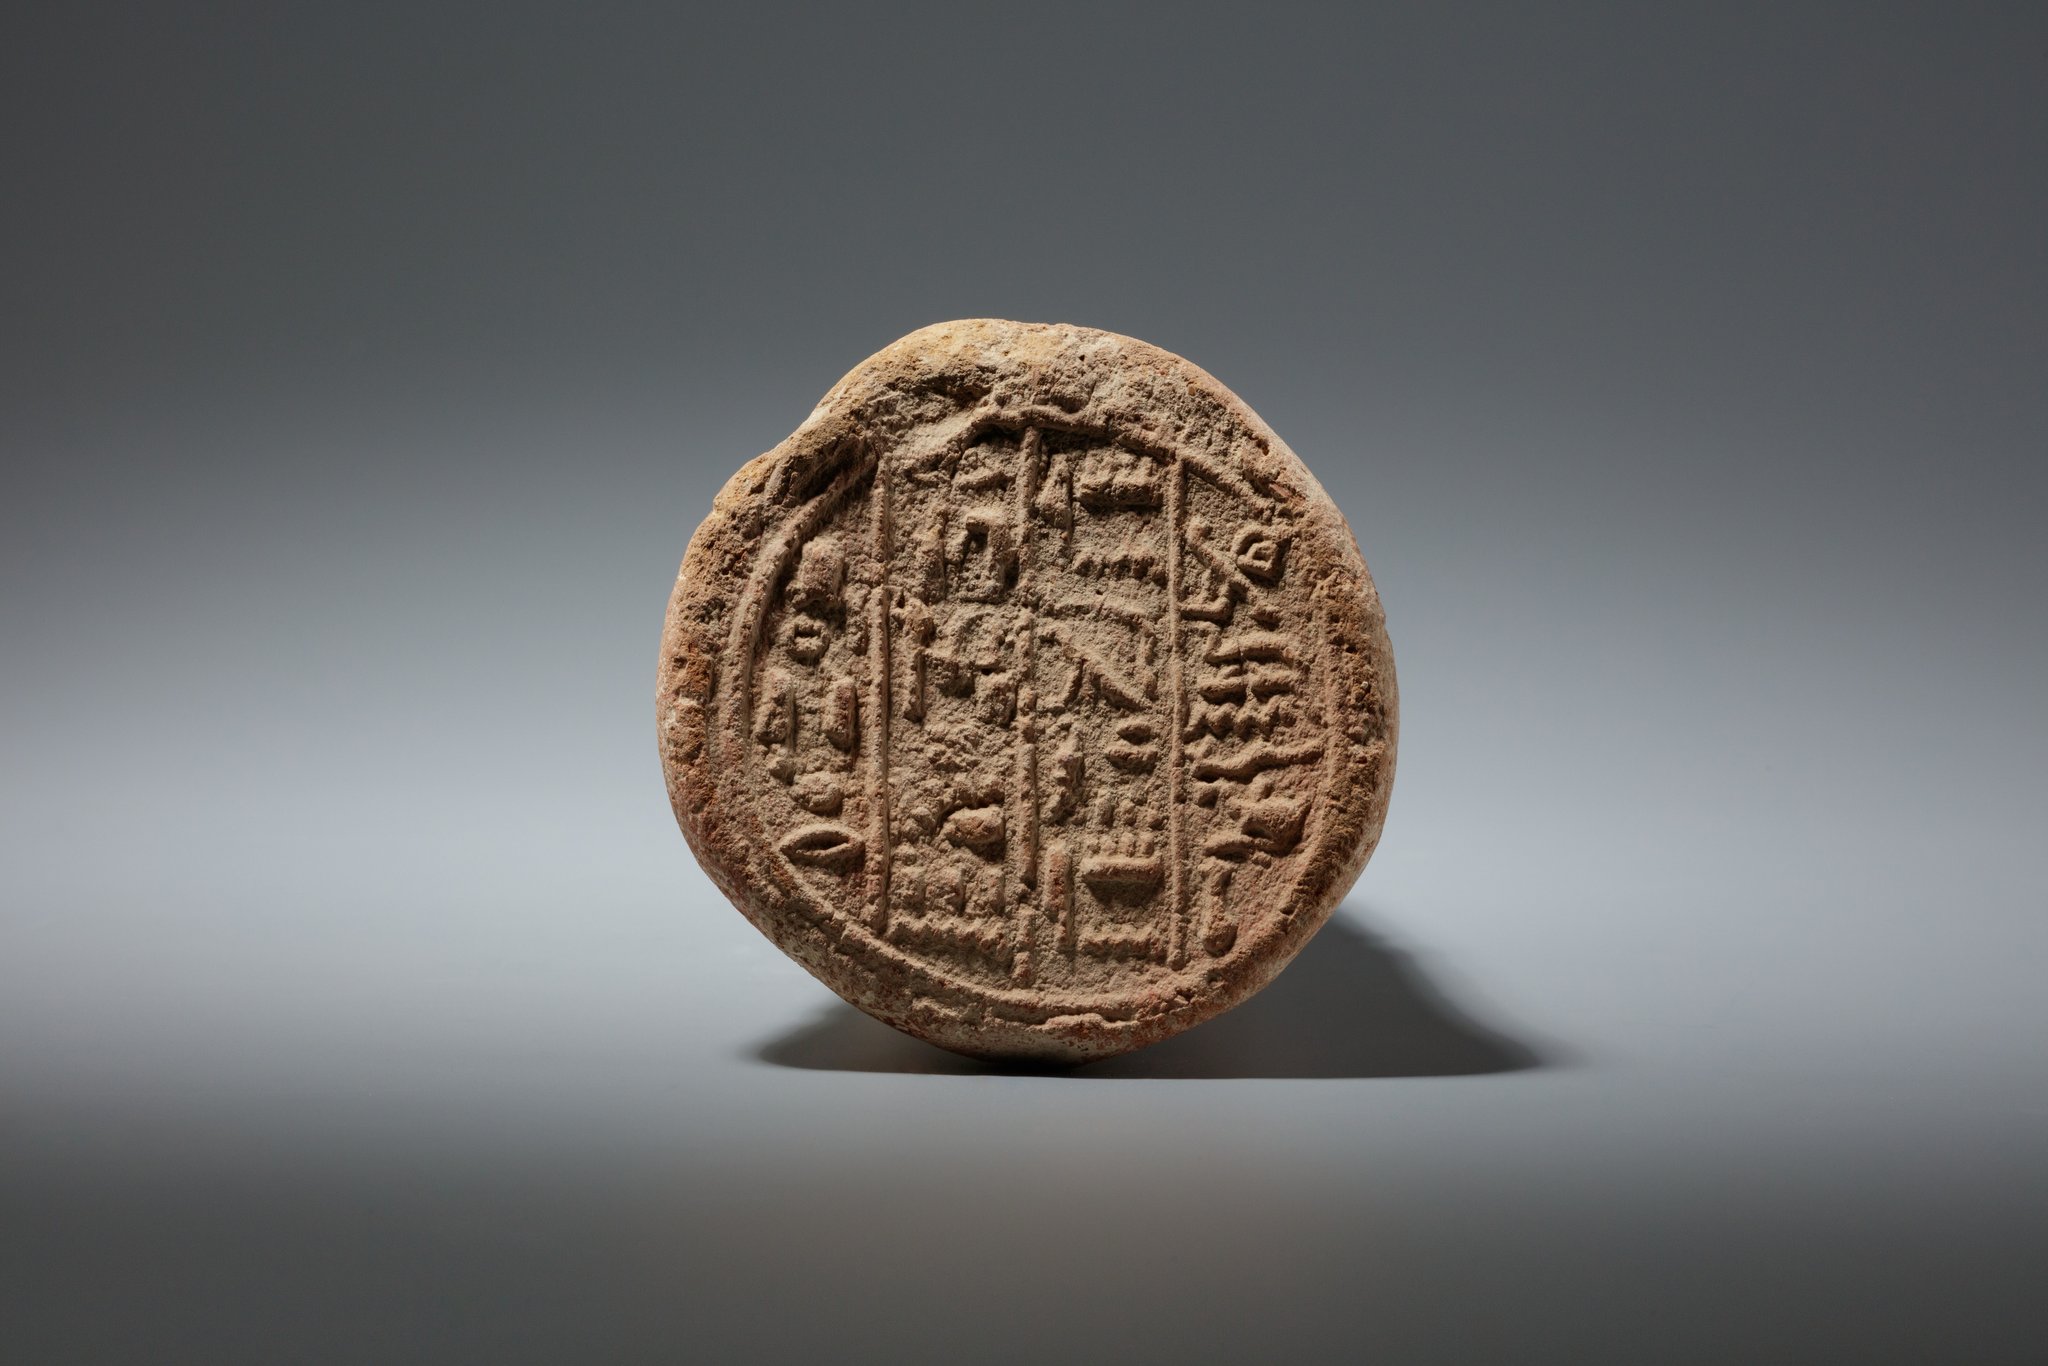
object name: cone, davy 73, amenemopet, tjanefer, scribe, grain of amun, field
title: Funerary Cone of the Scribe Amenemopet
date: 1400-1352 BCE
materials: pottery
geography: egypt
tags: hieroglyphs